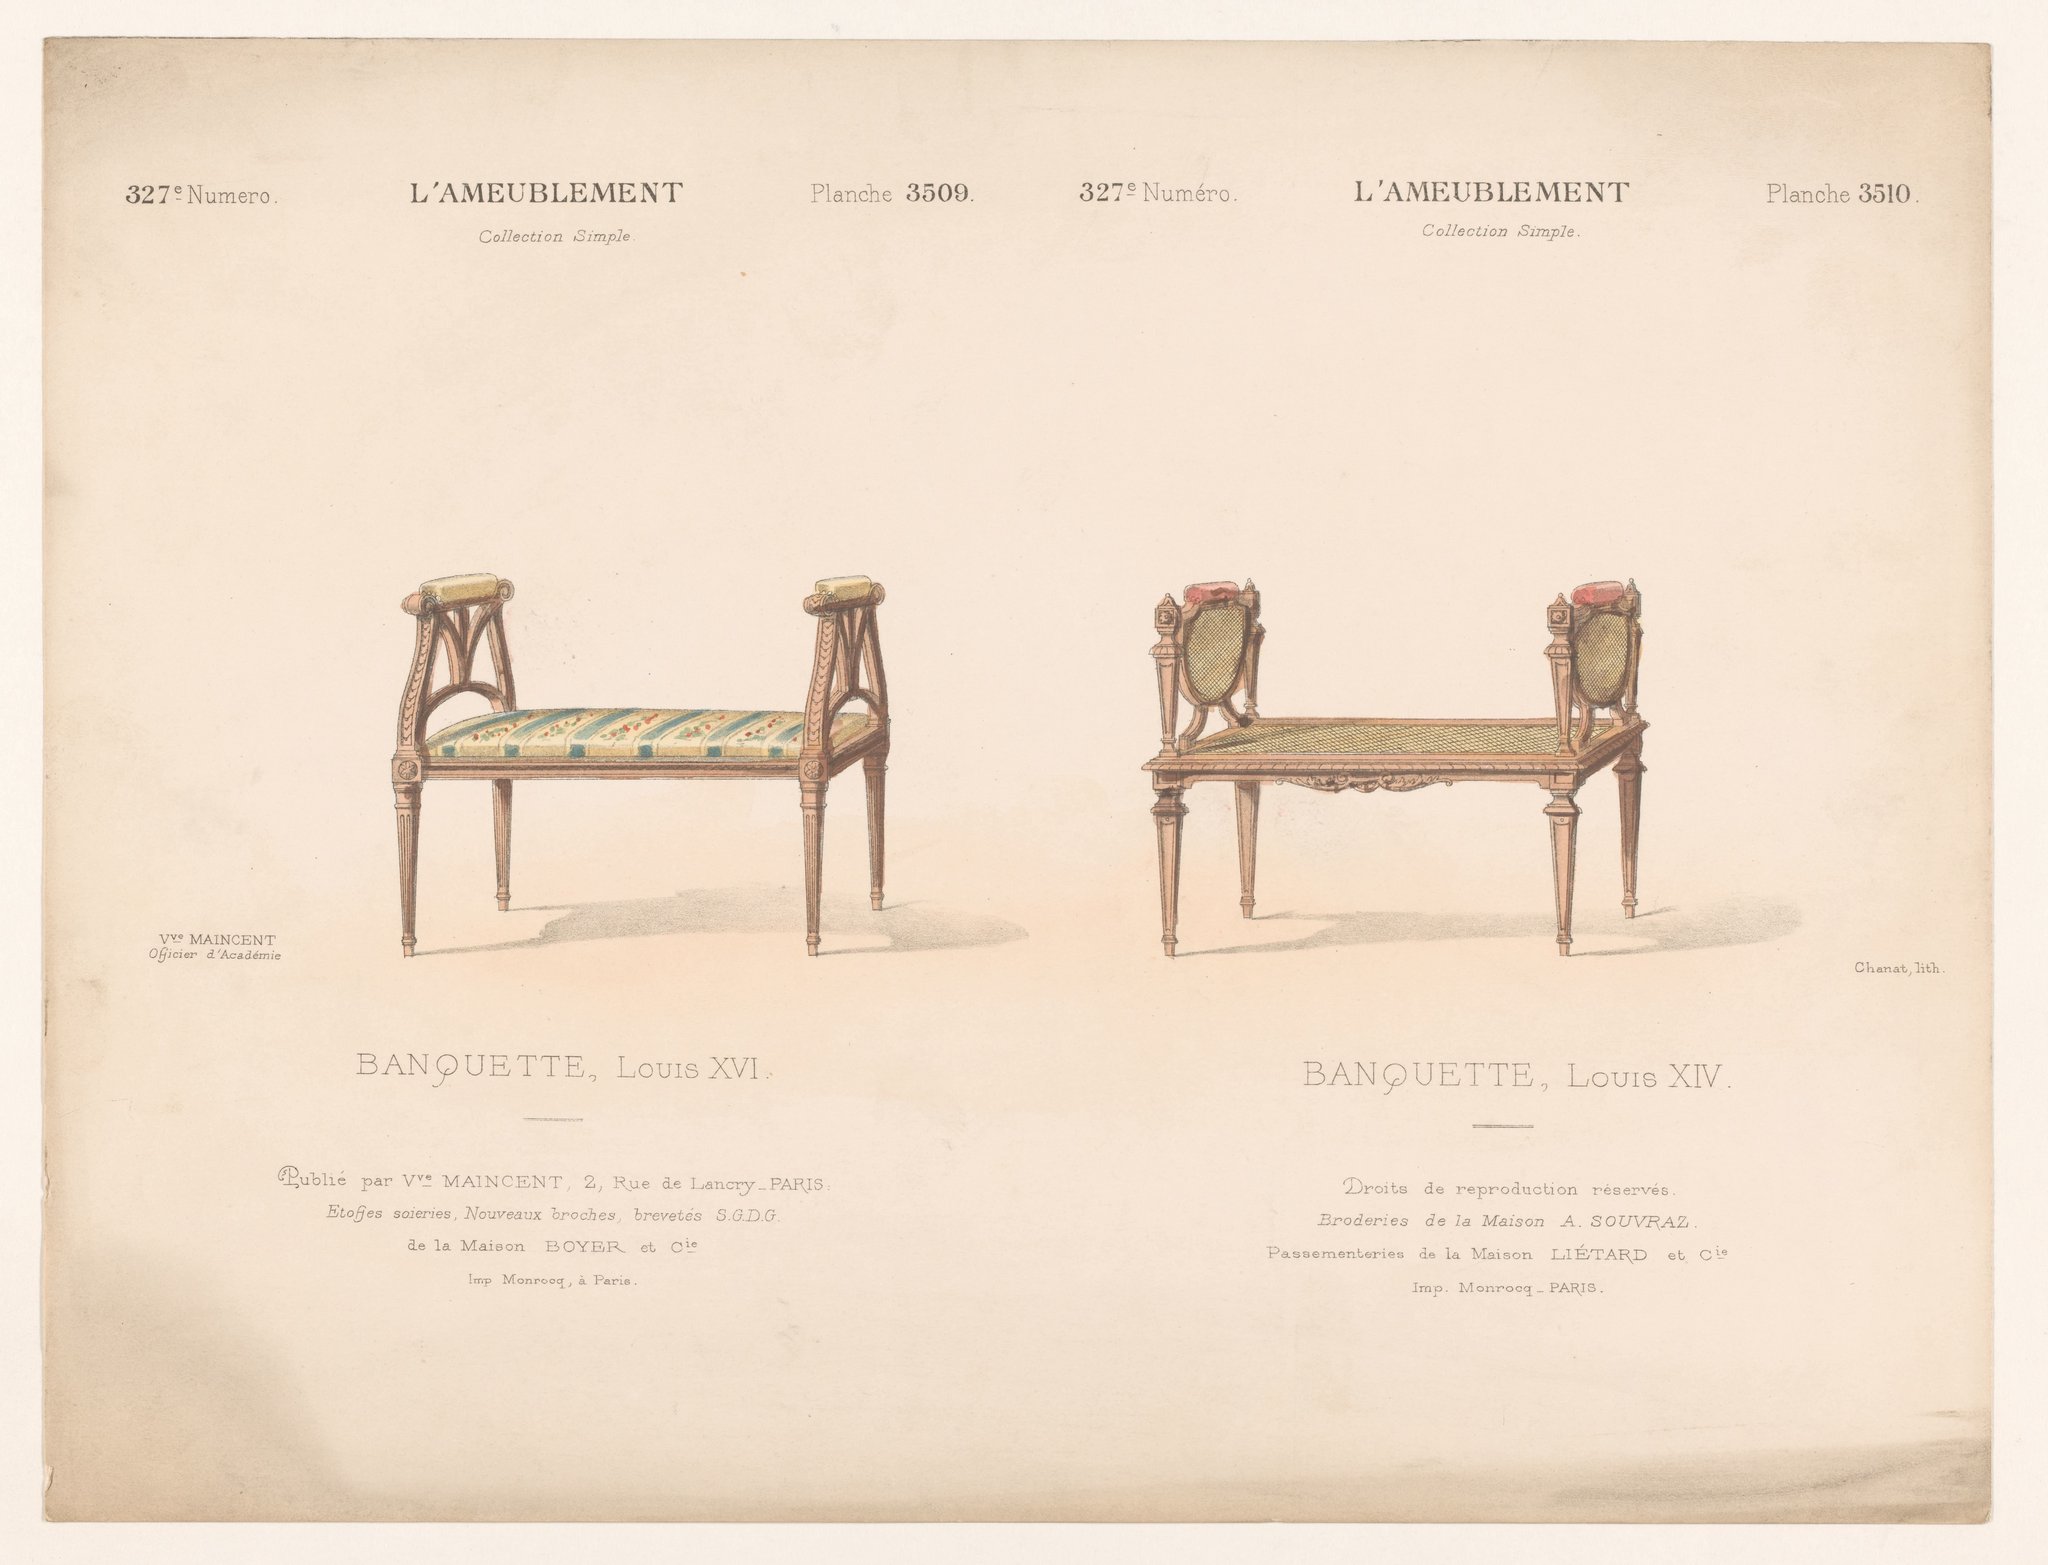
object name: print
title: Banquette, Louis XVI / Banquette, Louis XIV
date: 1895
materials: paper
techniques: hand coloring, lithograph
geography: paris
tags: seating furniture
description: Twee banken in de stijlen van Lodewijk XVI en Lodewijk XIV. Prent uit 327e nummer (livraison).